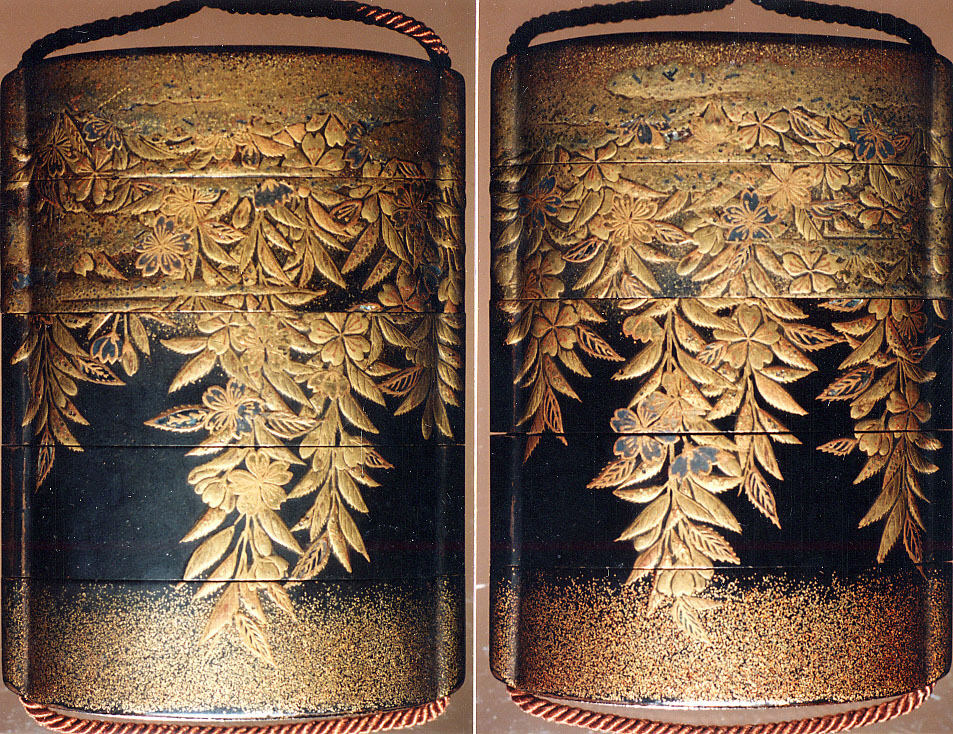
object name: inrō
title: Case (Inrō) with Design of Flowering Weeping Cherry Branches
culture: japanese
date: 1701-1900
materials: gold, lacquer, silver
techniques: fundame, hiramakie, roiro, maki-e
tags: flowers